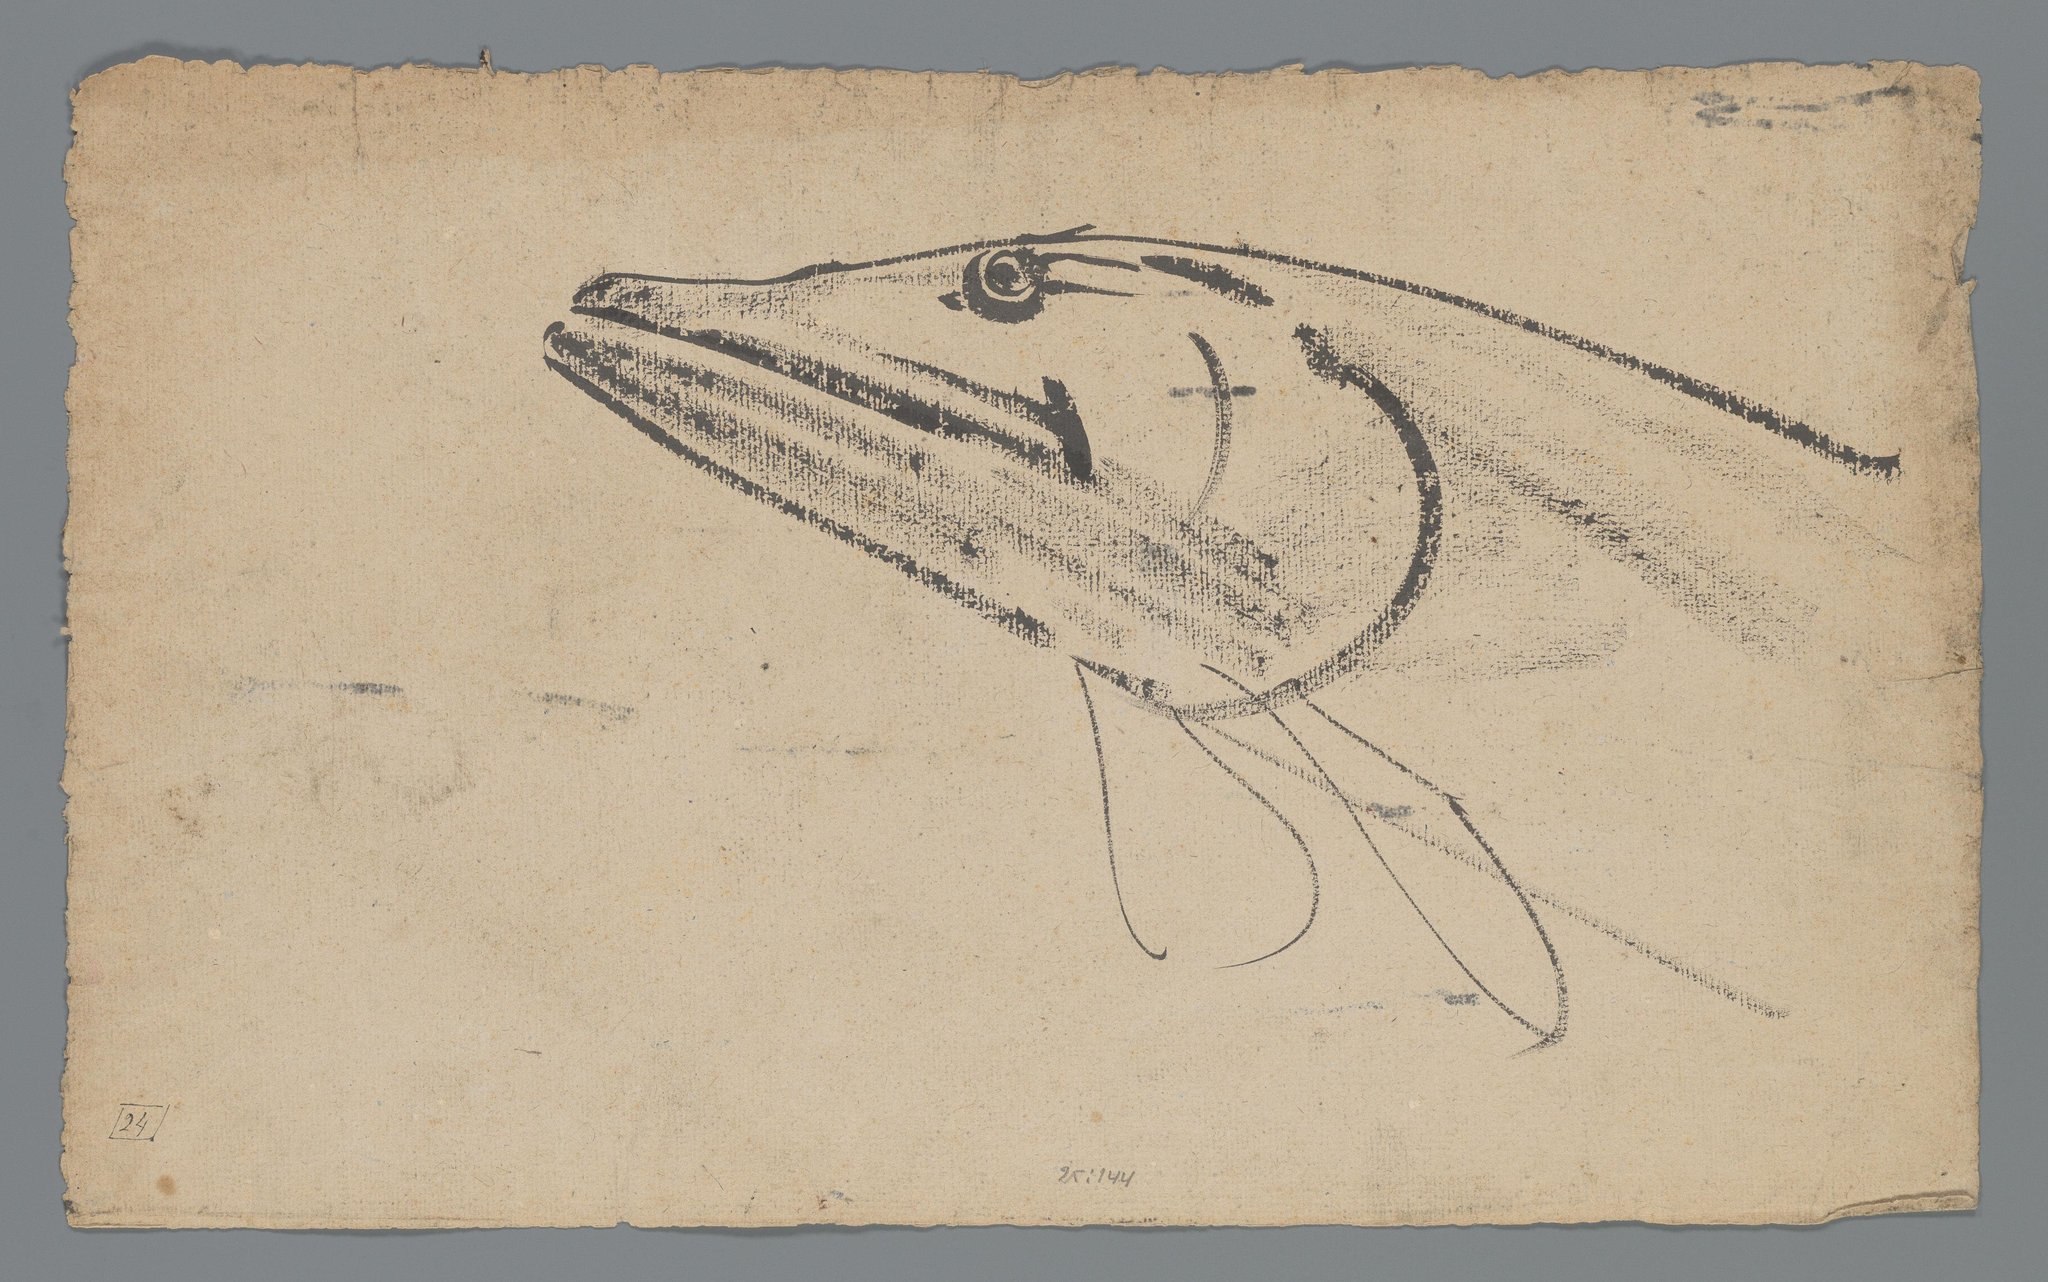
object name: drawing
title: Studie van een vis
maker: gerrit willem dijsselhof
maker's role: designer, draughtsman, print maker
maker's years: 1866-1924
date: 1876-1924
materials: paper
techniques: brush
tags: fishes